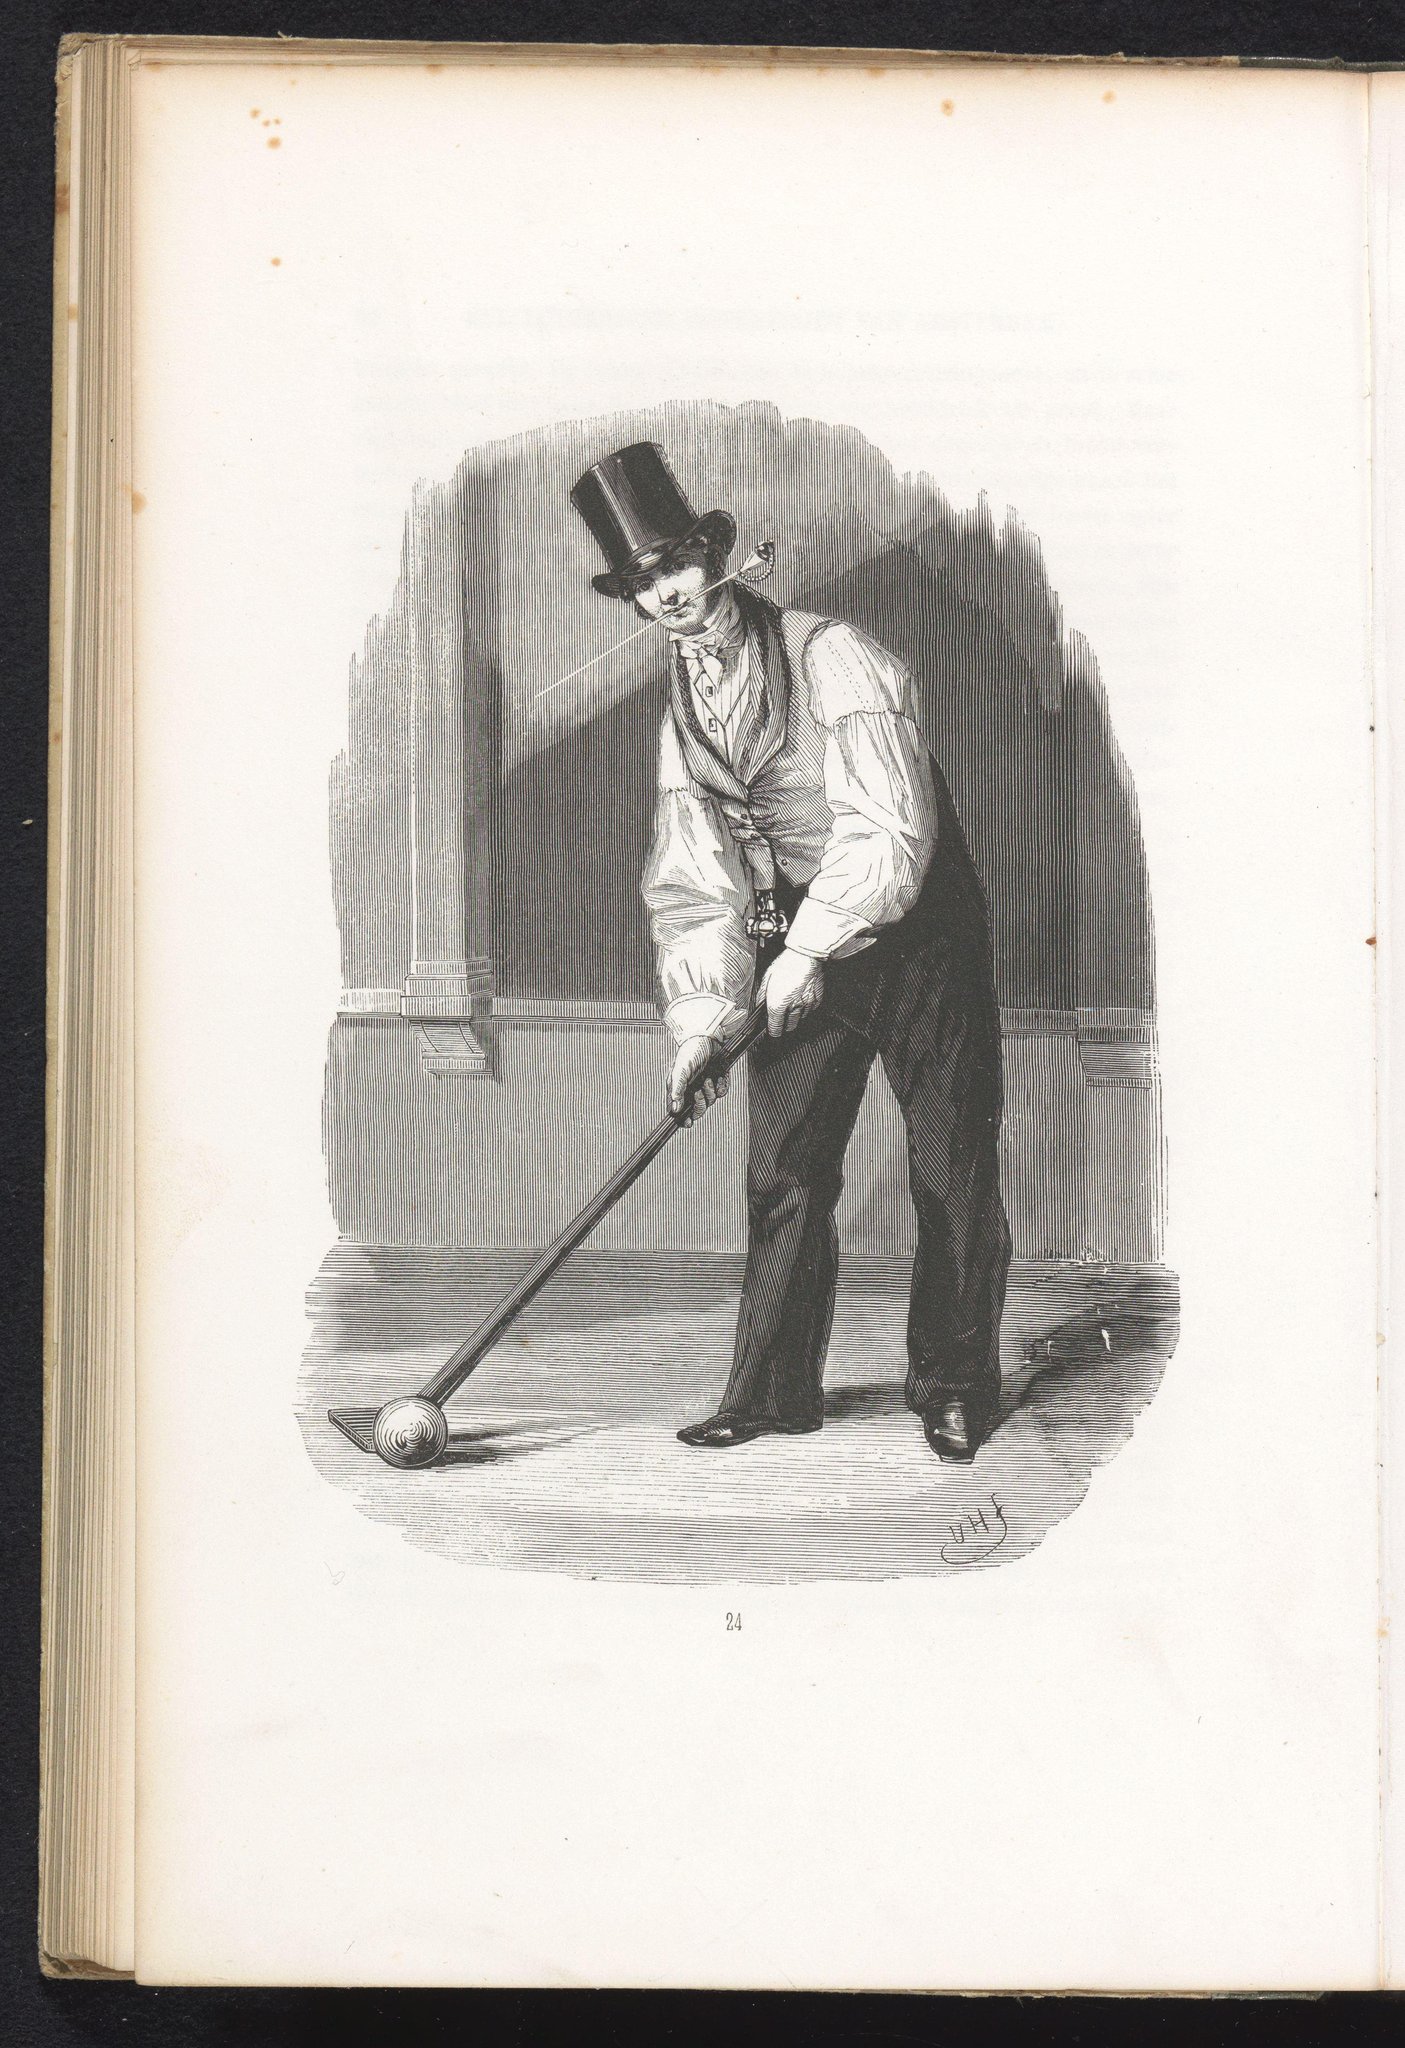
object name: print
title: De kolver, 1840-1841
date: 1841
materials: paper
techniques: letterpress printing, engraving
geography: netherlands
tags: professional clothes, 'kolf' (ball game), amsterdam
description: De kolver, of kolfspeler. Een jonge man staat gereed om de bal te slaan, zijn Goudse pijp met lange steel houdt hij in de mond. Genummerd: 24. Illustratie in het boek 'De Nederlanden: karakterschetsen, kleederdrachten, houding en voorkomen van verschillende standen', een boek met karakterschetsen, beroepen en klederdrachten van Nederlandse volkstypen uit 1841.